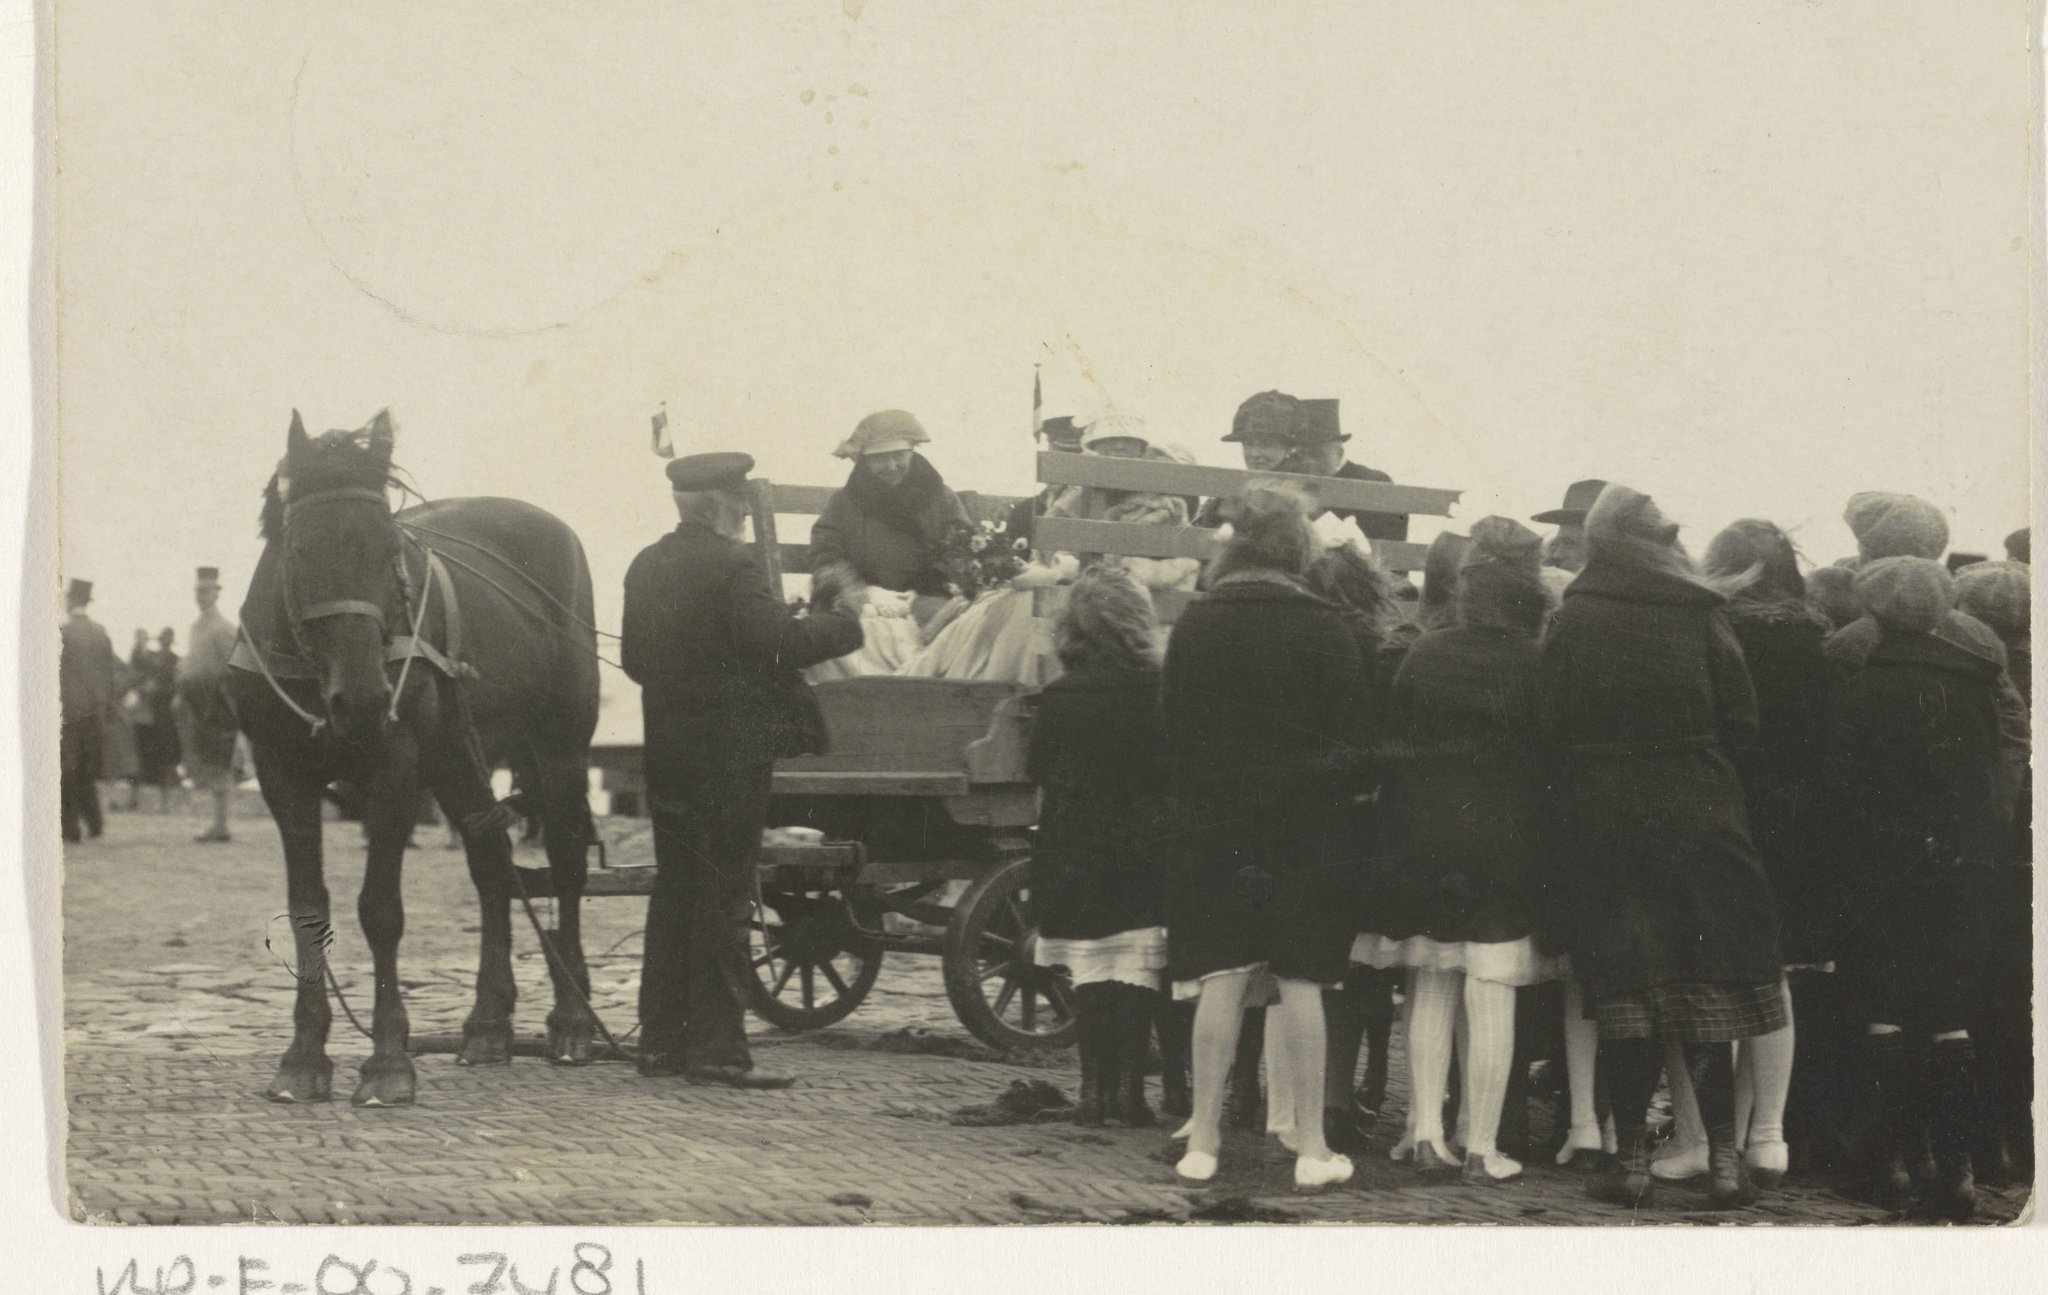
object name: ansichtkaart, prentbriefkaart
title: Wilhelmina, koningin der Nederlanden, en Juliana, koningin der Nederlanden, in een rijtuig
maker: Anonymous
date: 1920-1930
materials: photographic support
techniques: photography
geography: netherlands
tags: the hague, print maker, wilhelmina of the netherlands, juliana of the netherlands, animal traction, animal-drawn vehicle (carriage etc.)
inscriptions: inscription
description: De hier vermelde titel verwijst naar de hoogst verkregen titel van de geportretteerde, niet per se naar de titel die de geportretteerde op deze voorstelling draagt.